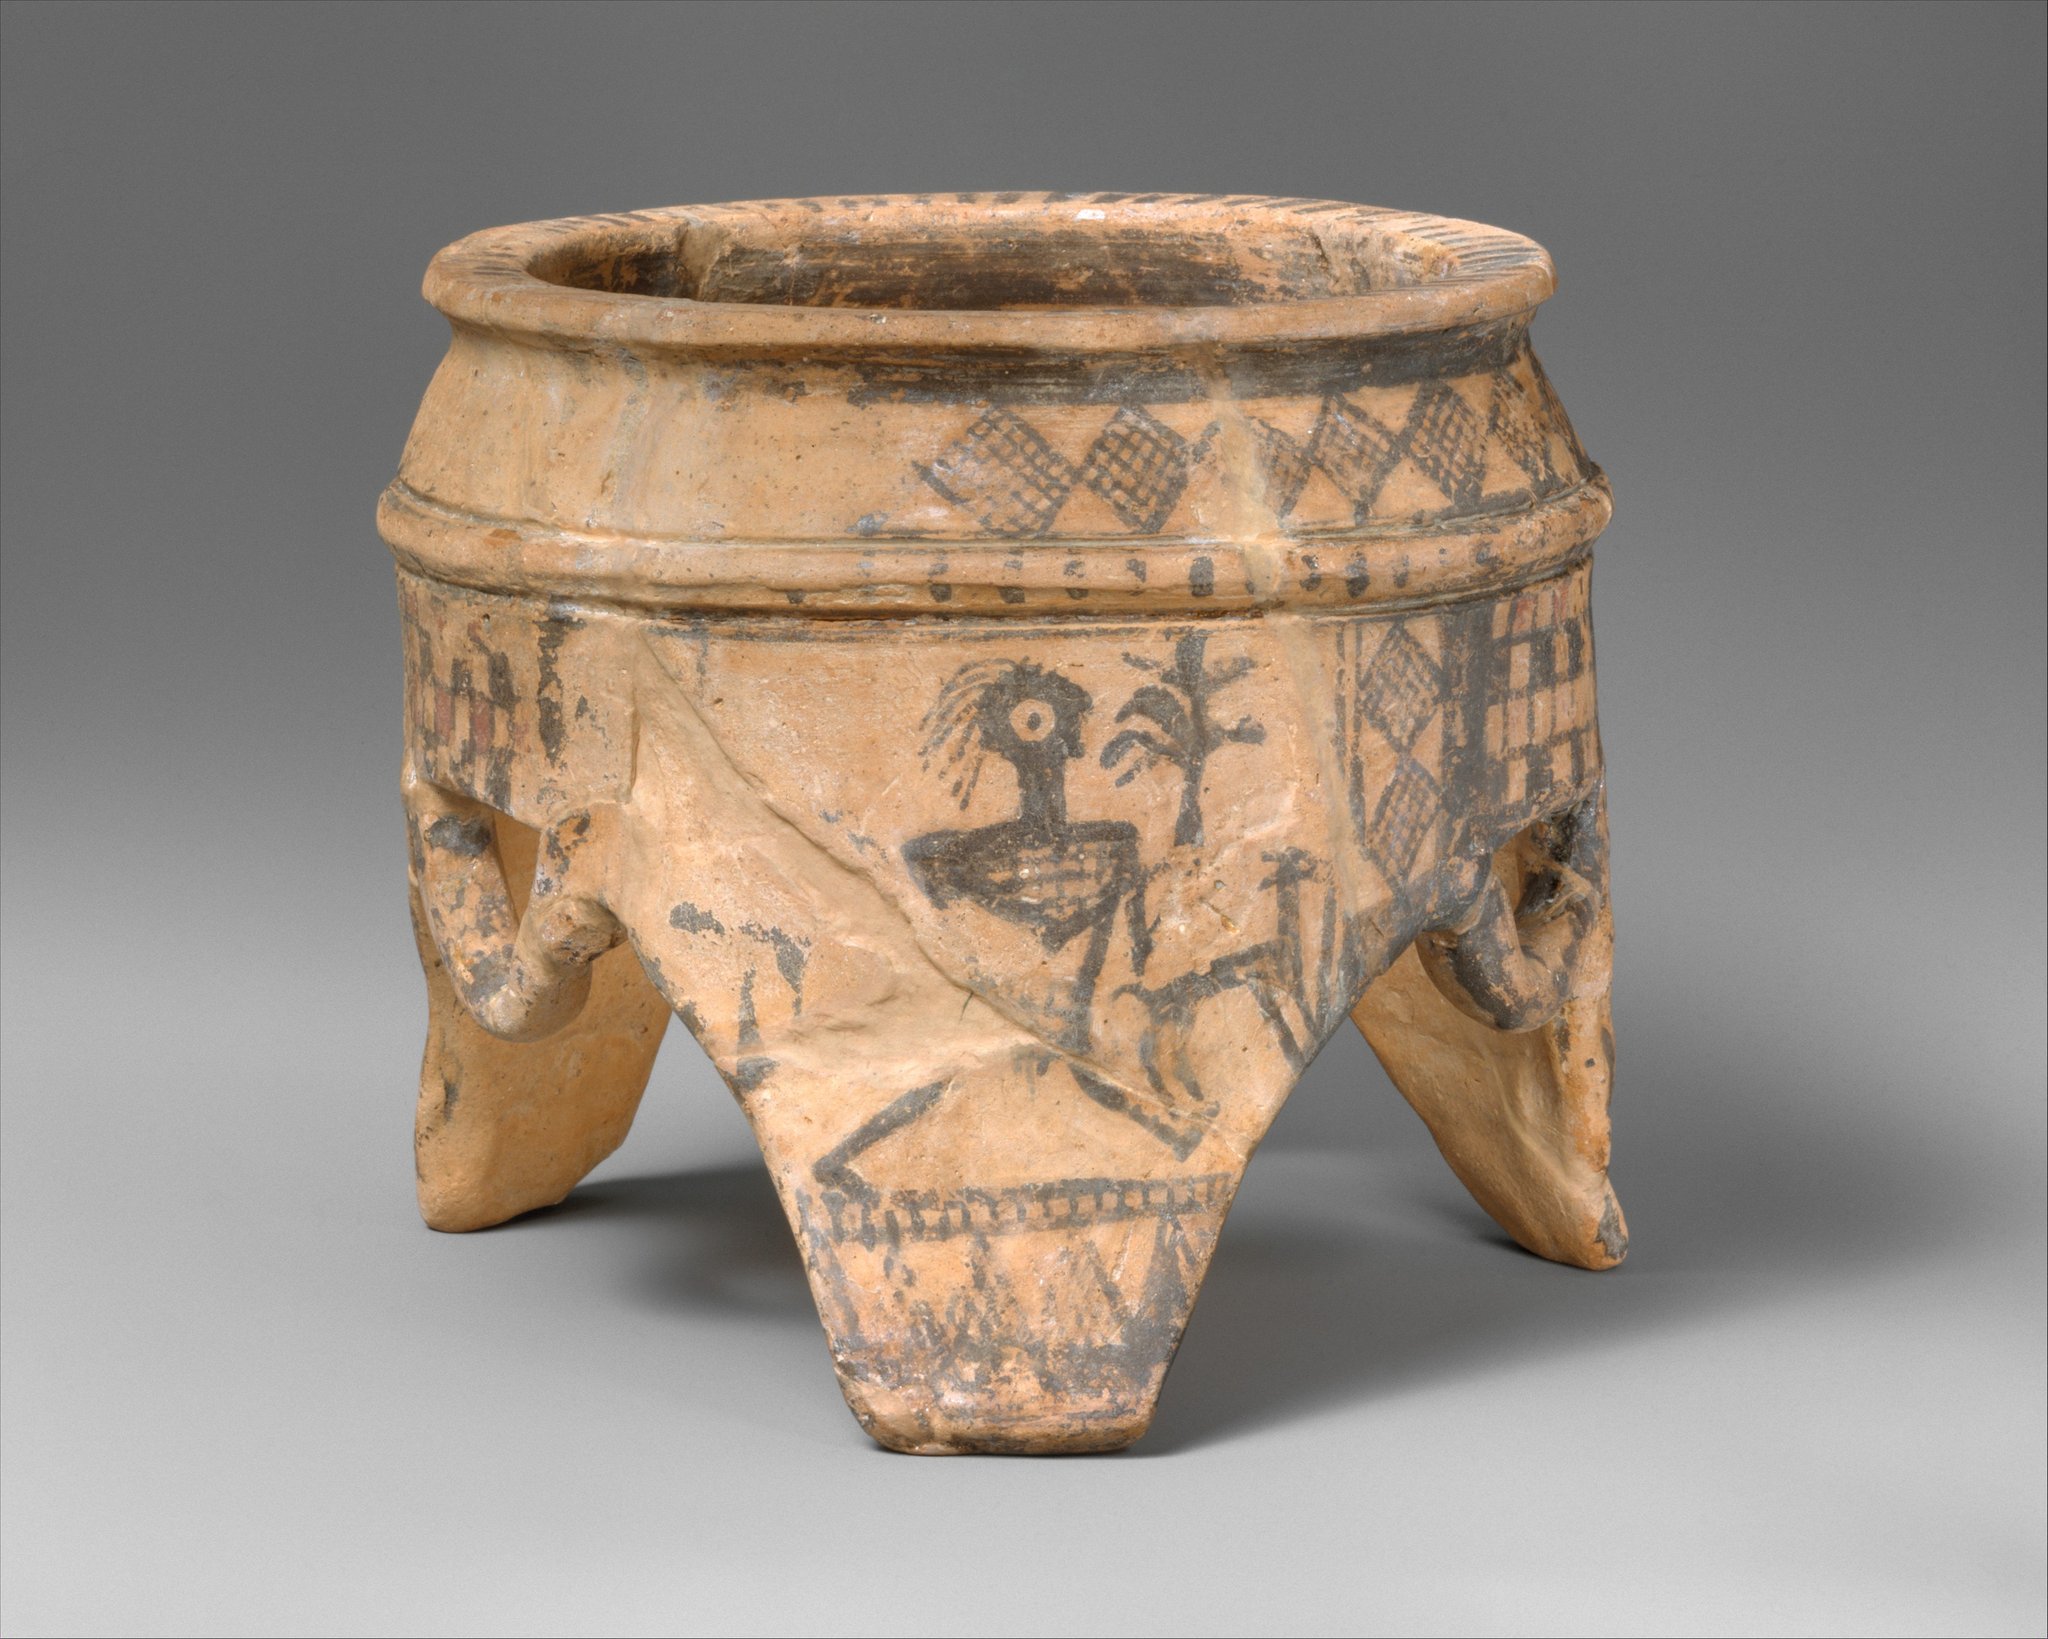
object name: tripod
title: Terracotta tripod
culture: cypriot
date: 1050-950 BCE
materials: terracotta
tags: animals,men